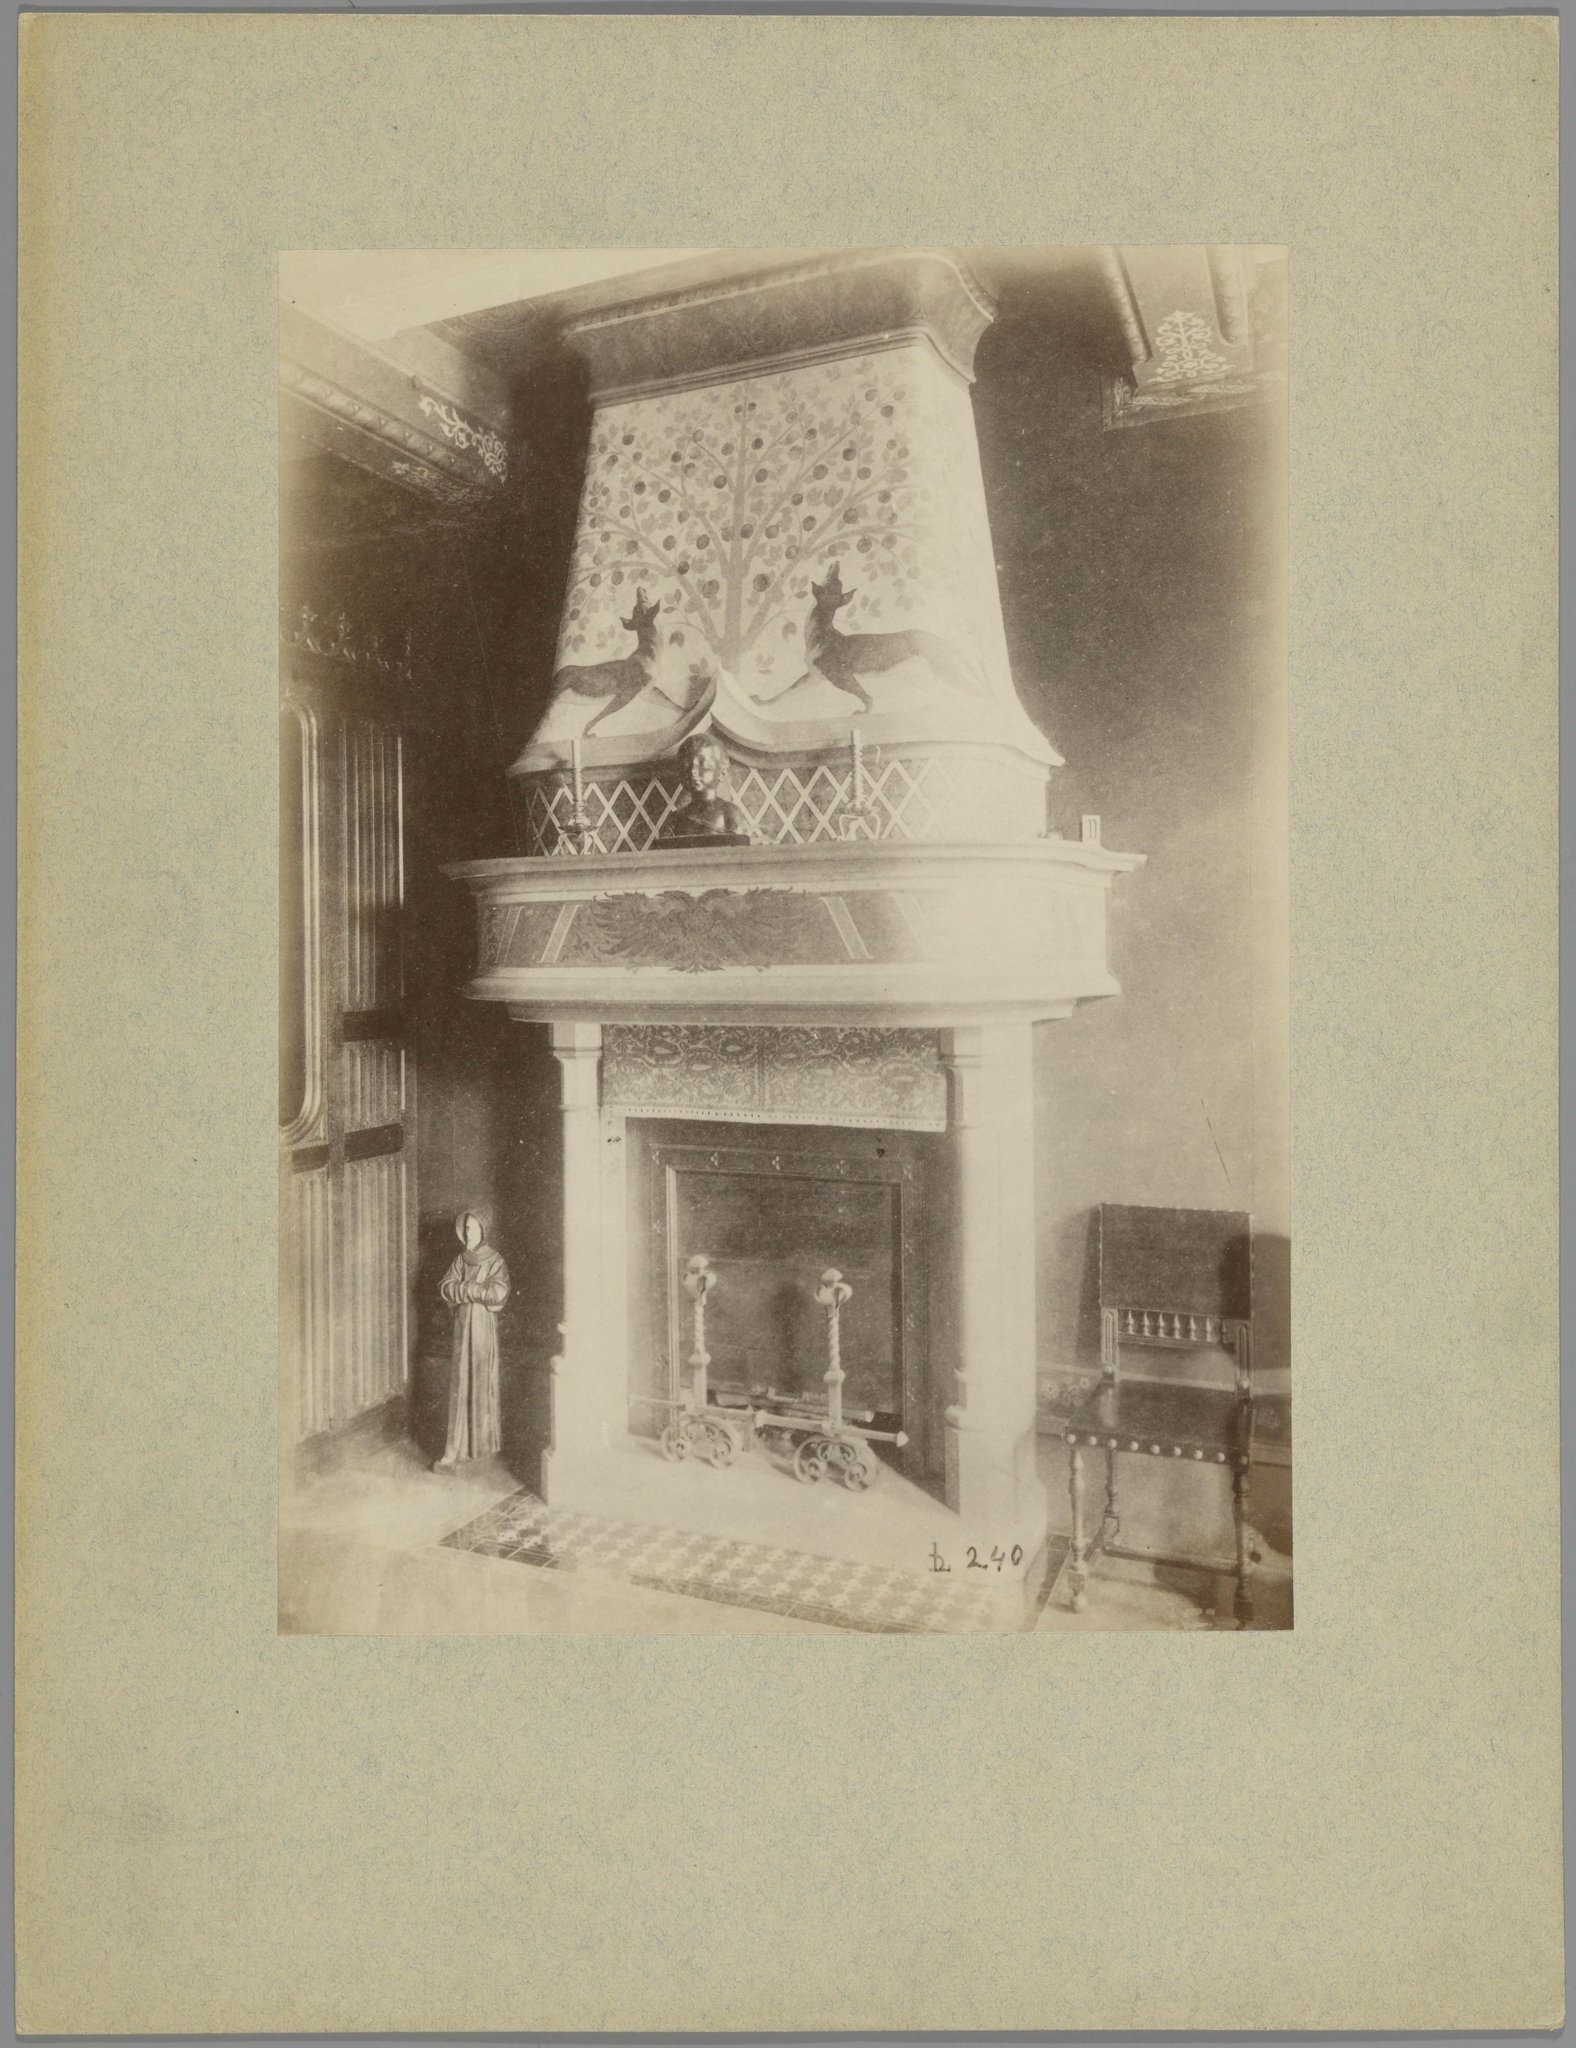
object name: photograph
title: Buste van een kind op schouw gedecoreerd met twee honden onder een boom met vruchten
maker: Anonymous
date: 1875-1900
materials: cardboard, photographic support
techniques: albumen print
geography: europe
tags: open hearth, fire-place, dog, europe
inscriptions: name: ‘KUNSTBOEKHANDEL J. A. G. DE LEUR PHOTOGRAAf - UITGEVER Huigenspark, 40b. DEN HAAG’, number: ‘[...] 240’, collector's mark: Lugt 3937